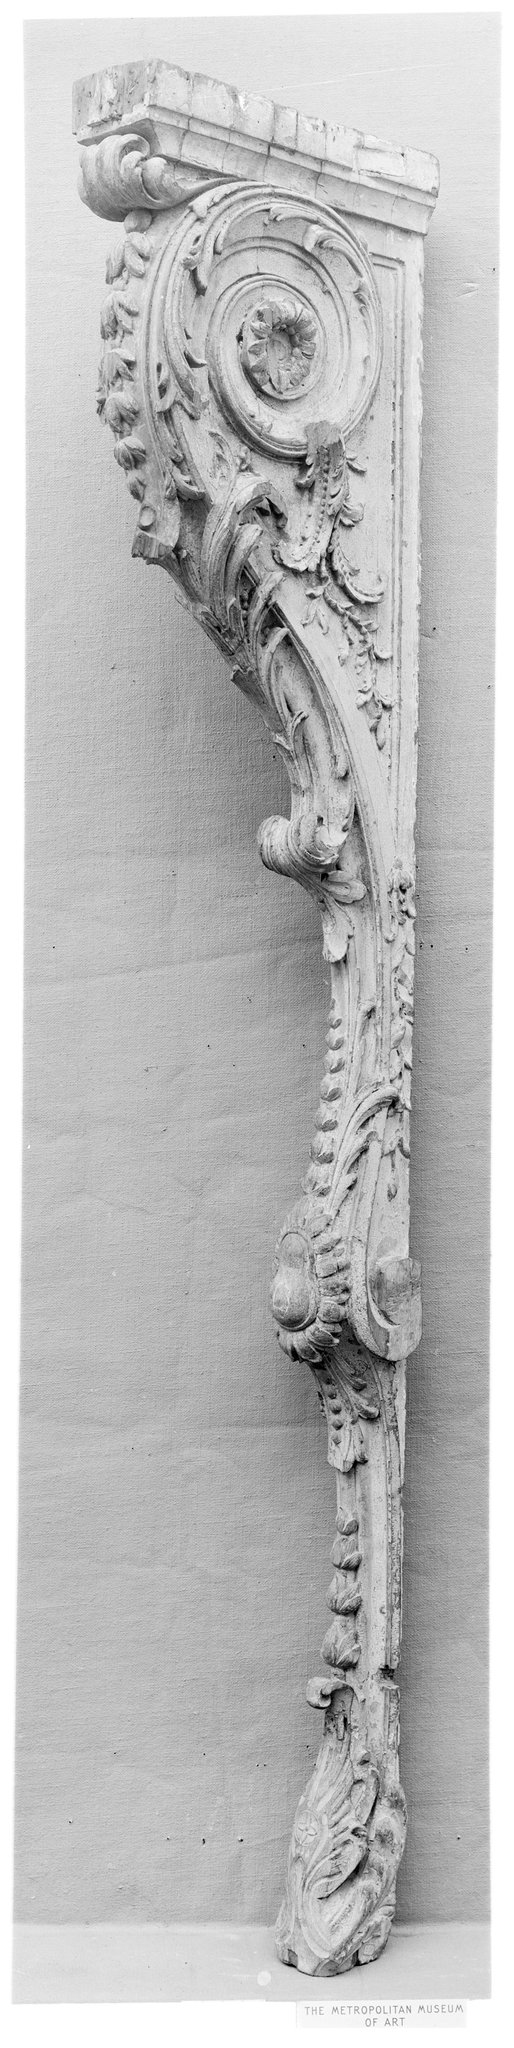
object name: montant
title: Upright (Montant)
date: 1701-1800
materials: wood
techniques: carving, painting